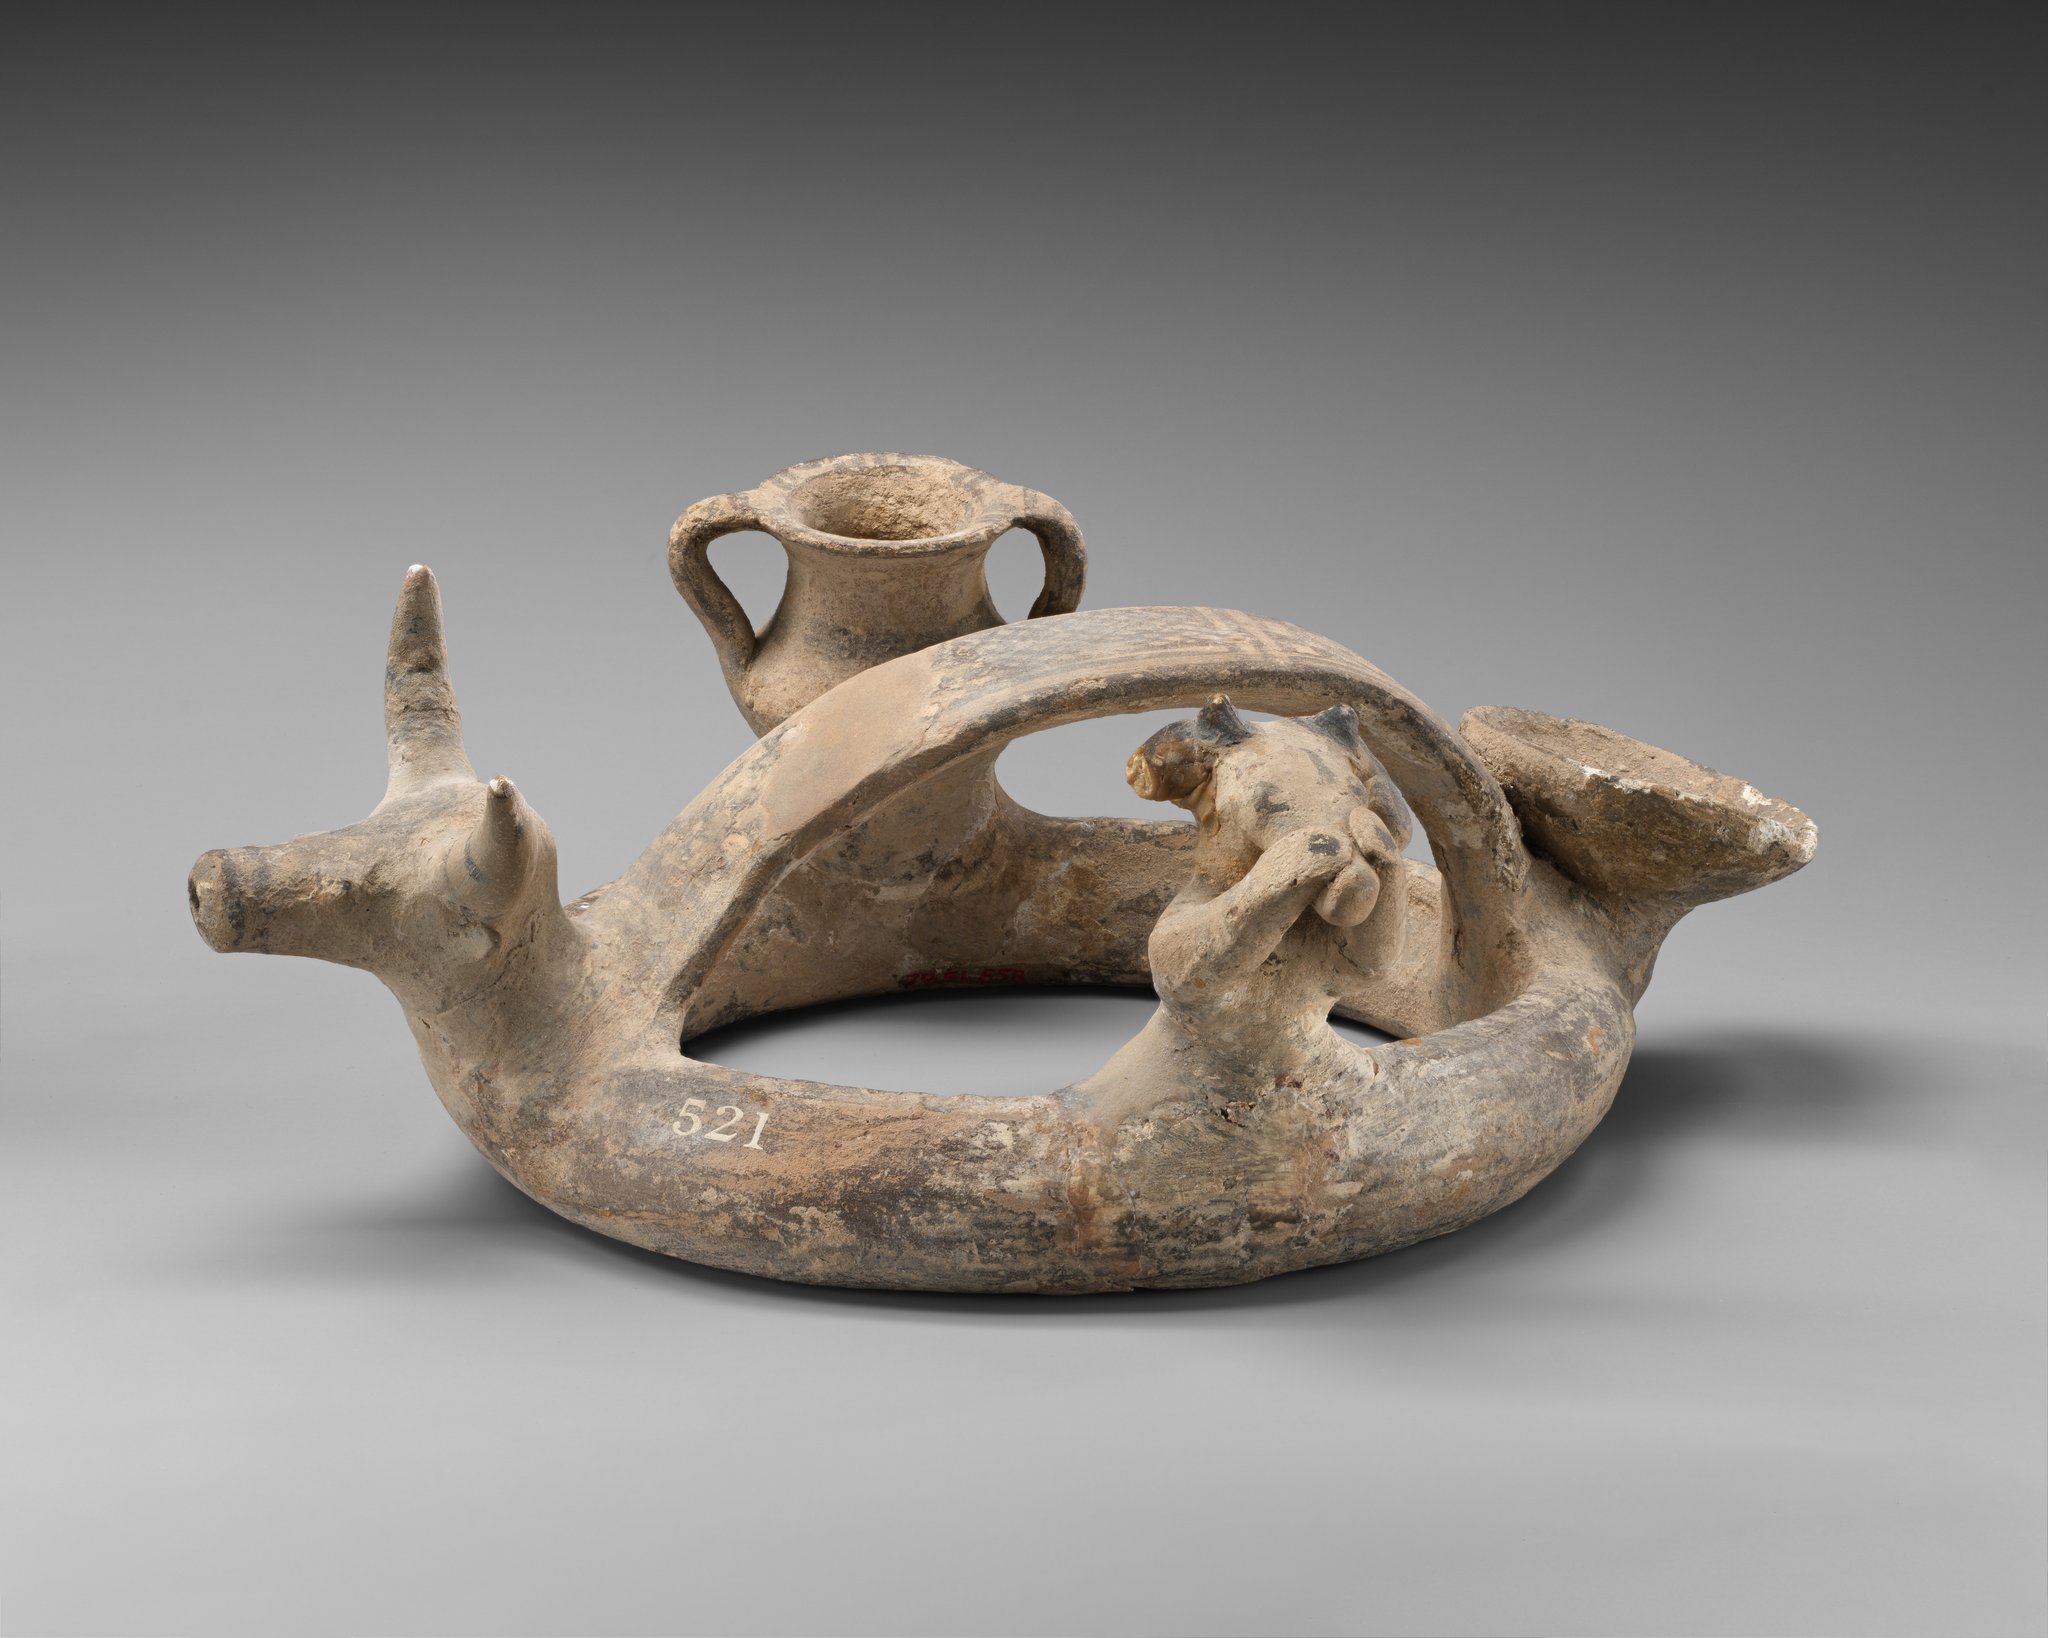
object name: ring vase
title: Ring-vase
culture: cypriot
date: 1050-950 BCE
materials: terracotta